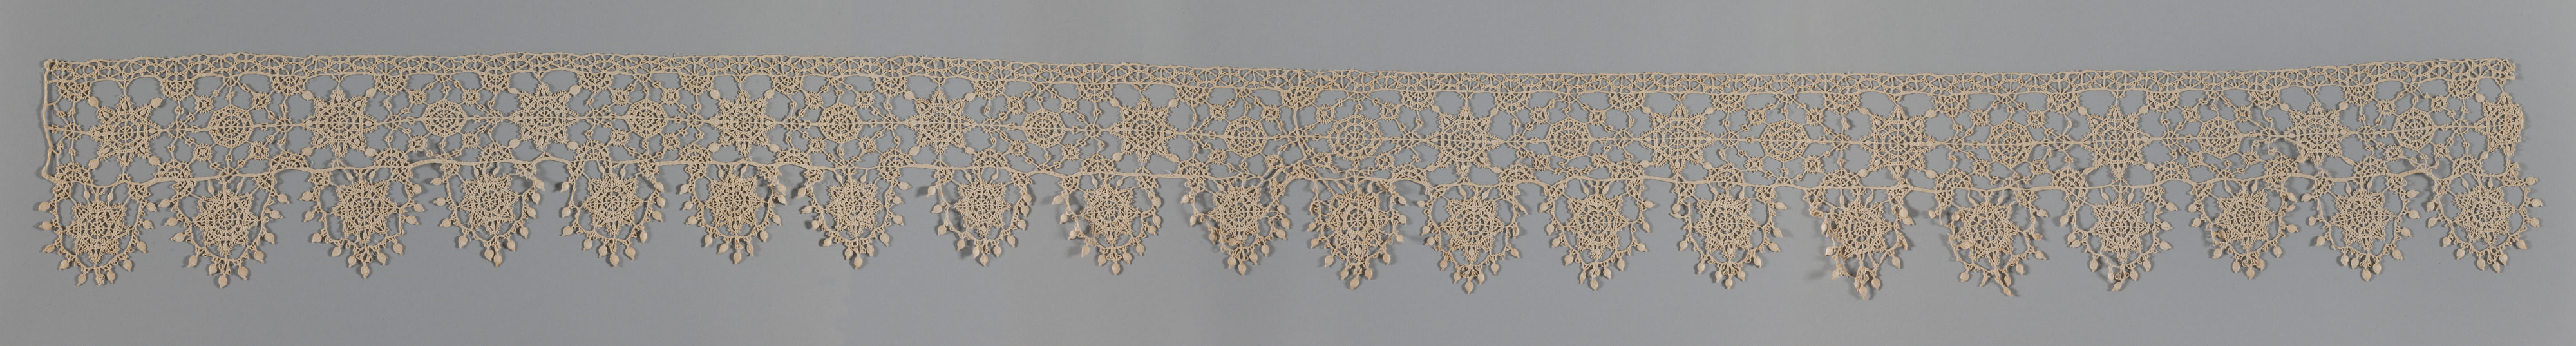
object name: border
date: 1601-1633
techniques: lace